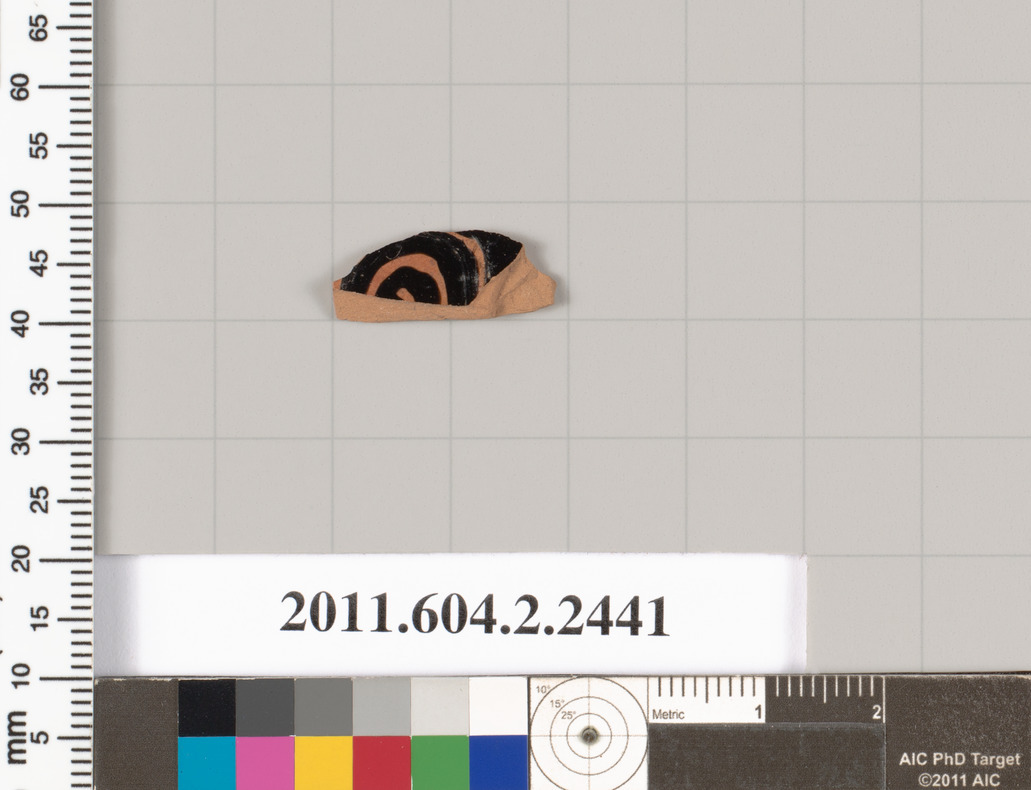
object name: undetermined shape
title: Terracotta fragment of an undetermined shape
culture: greek, attic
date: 600-501 BCE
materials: terracotta